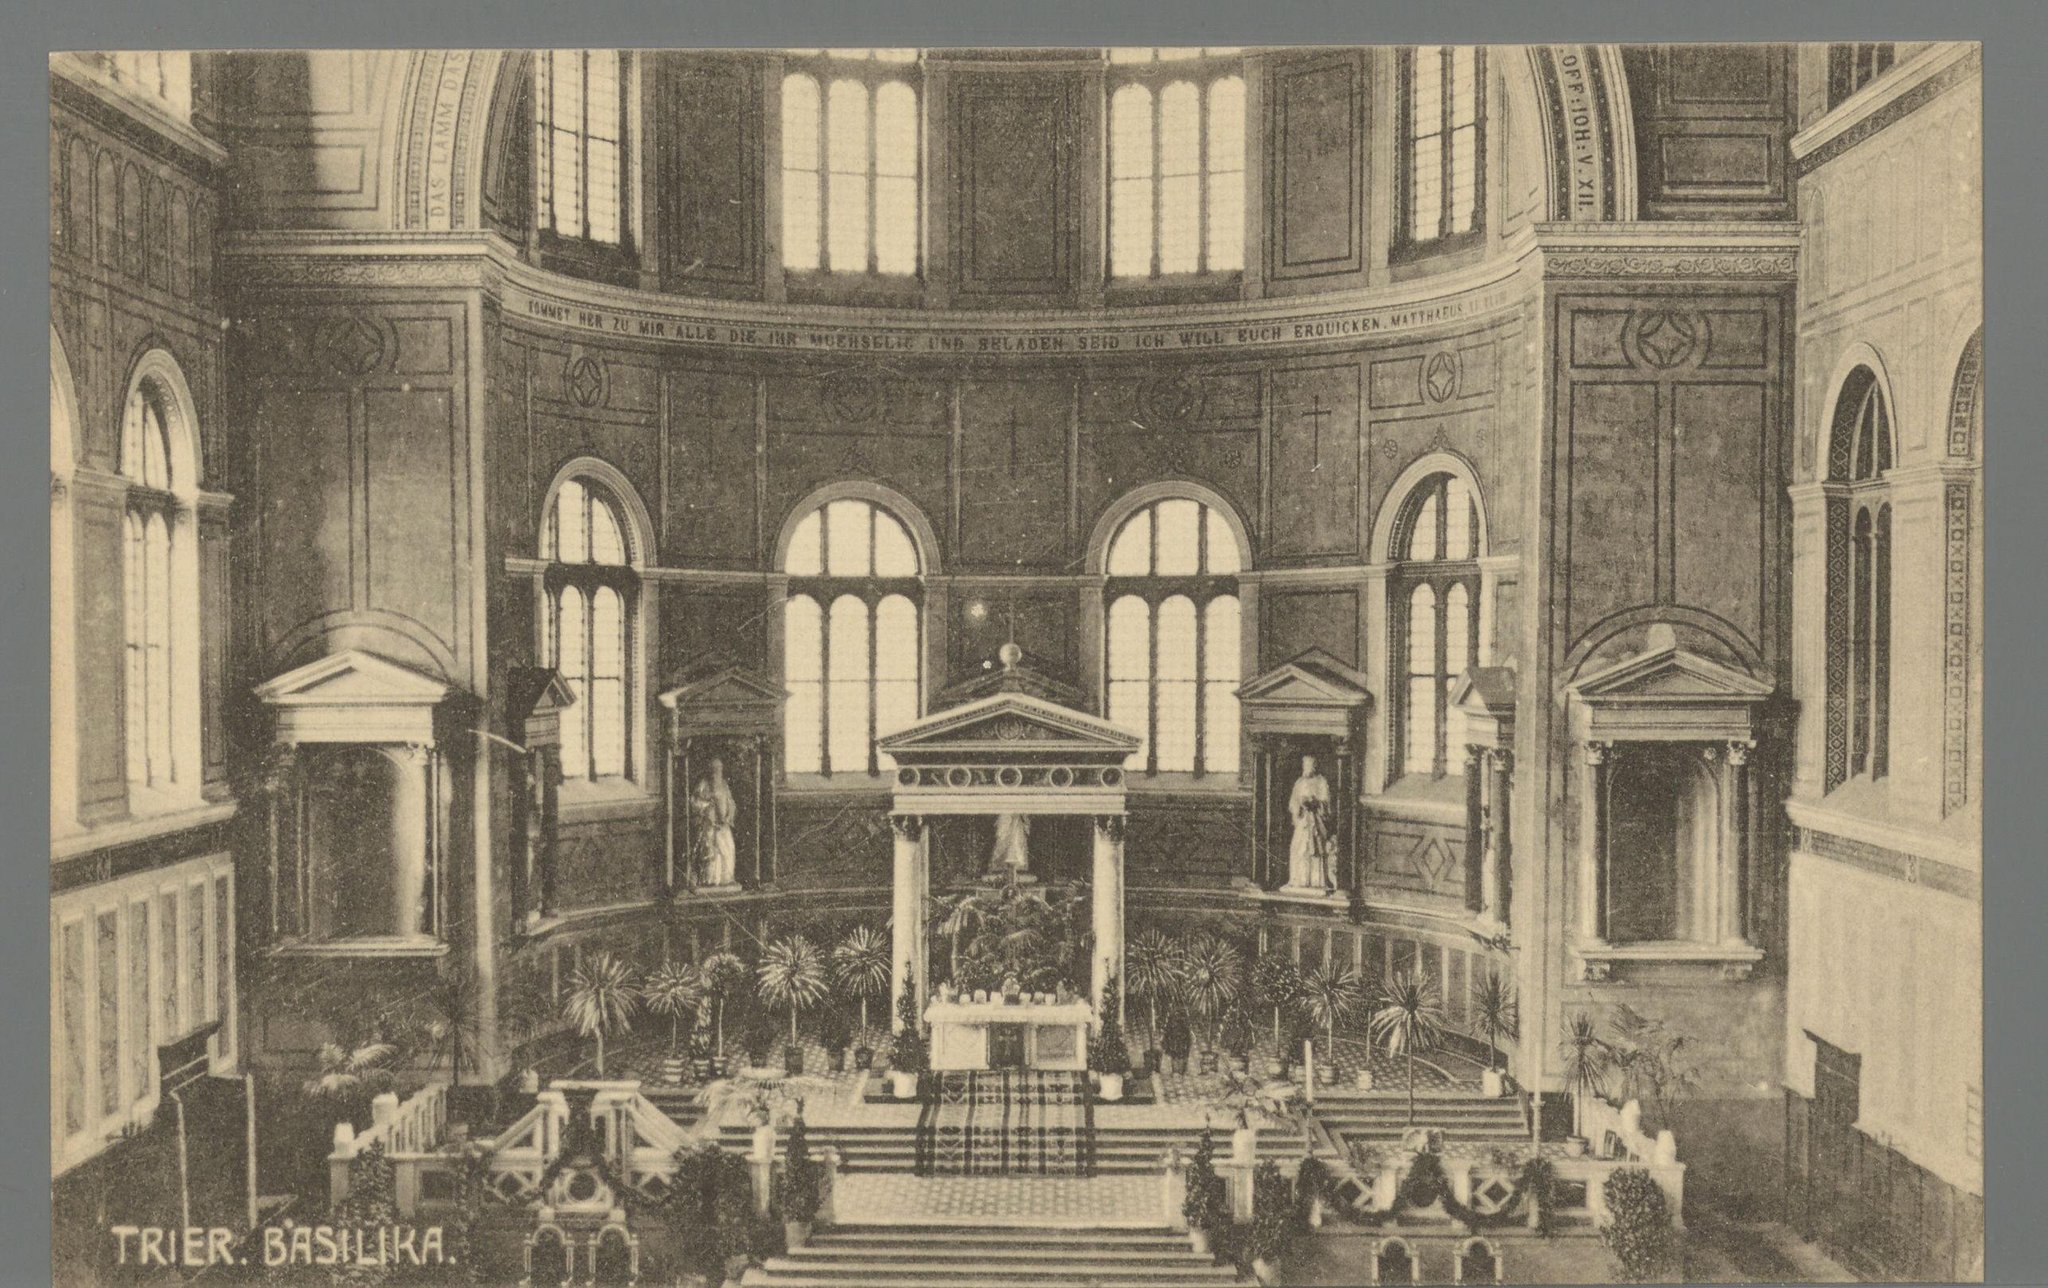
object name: ansichtkaart, prentbriefkaart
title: Trier. Basilika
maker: Anonymous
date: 1905-1930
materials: cardboard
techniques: photograph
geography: trier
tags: interior of church